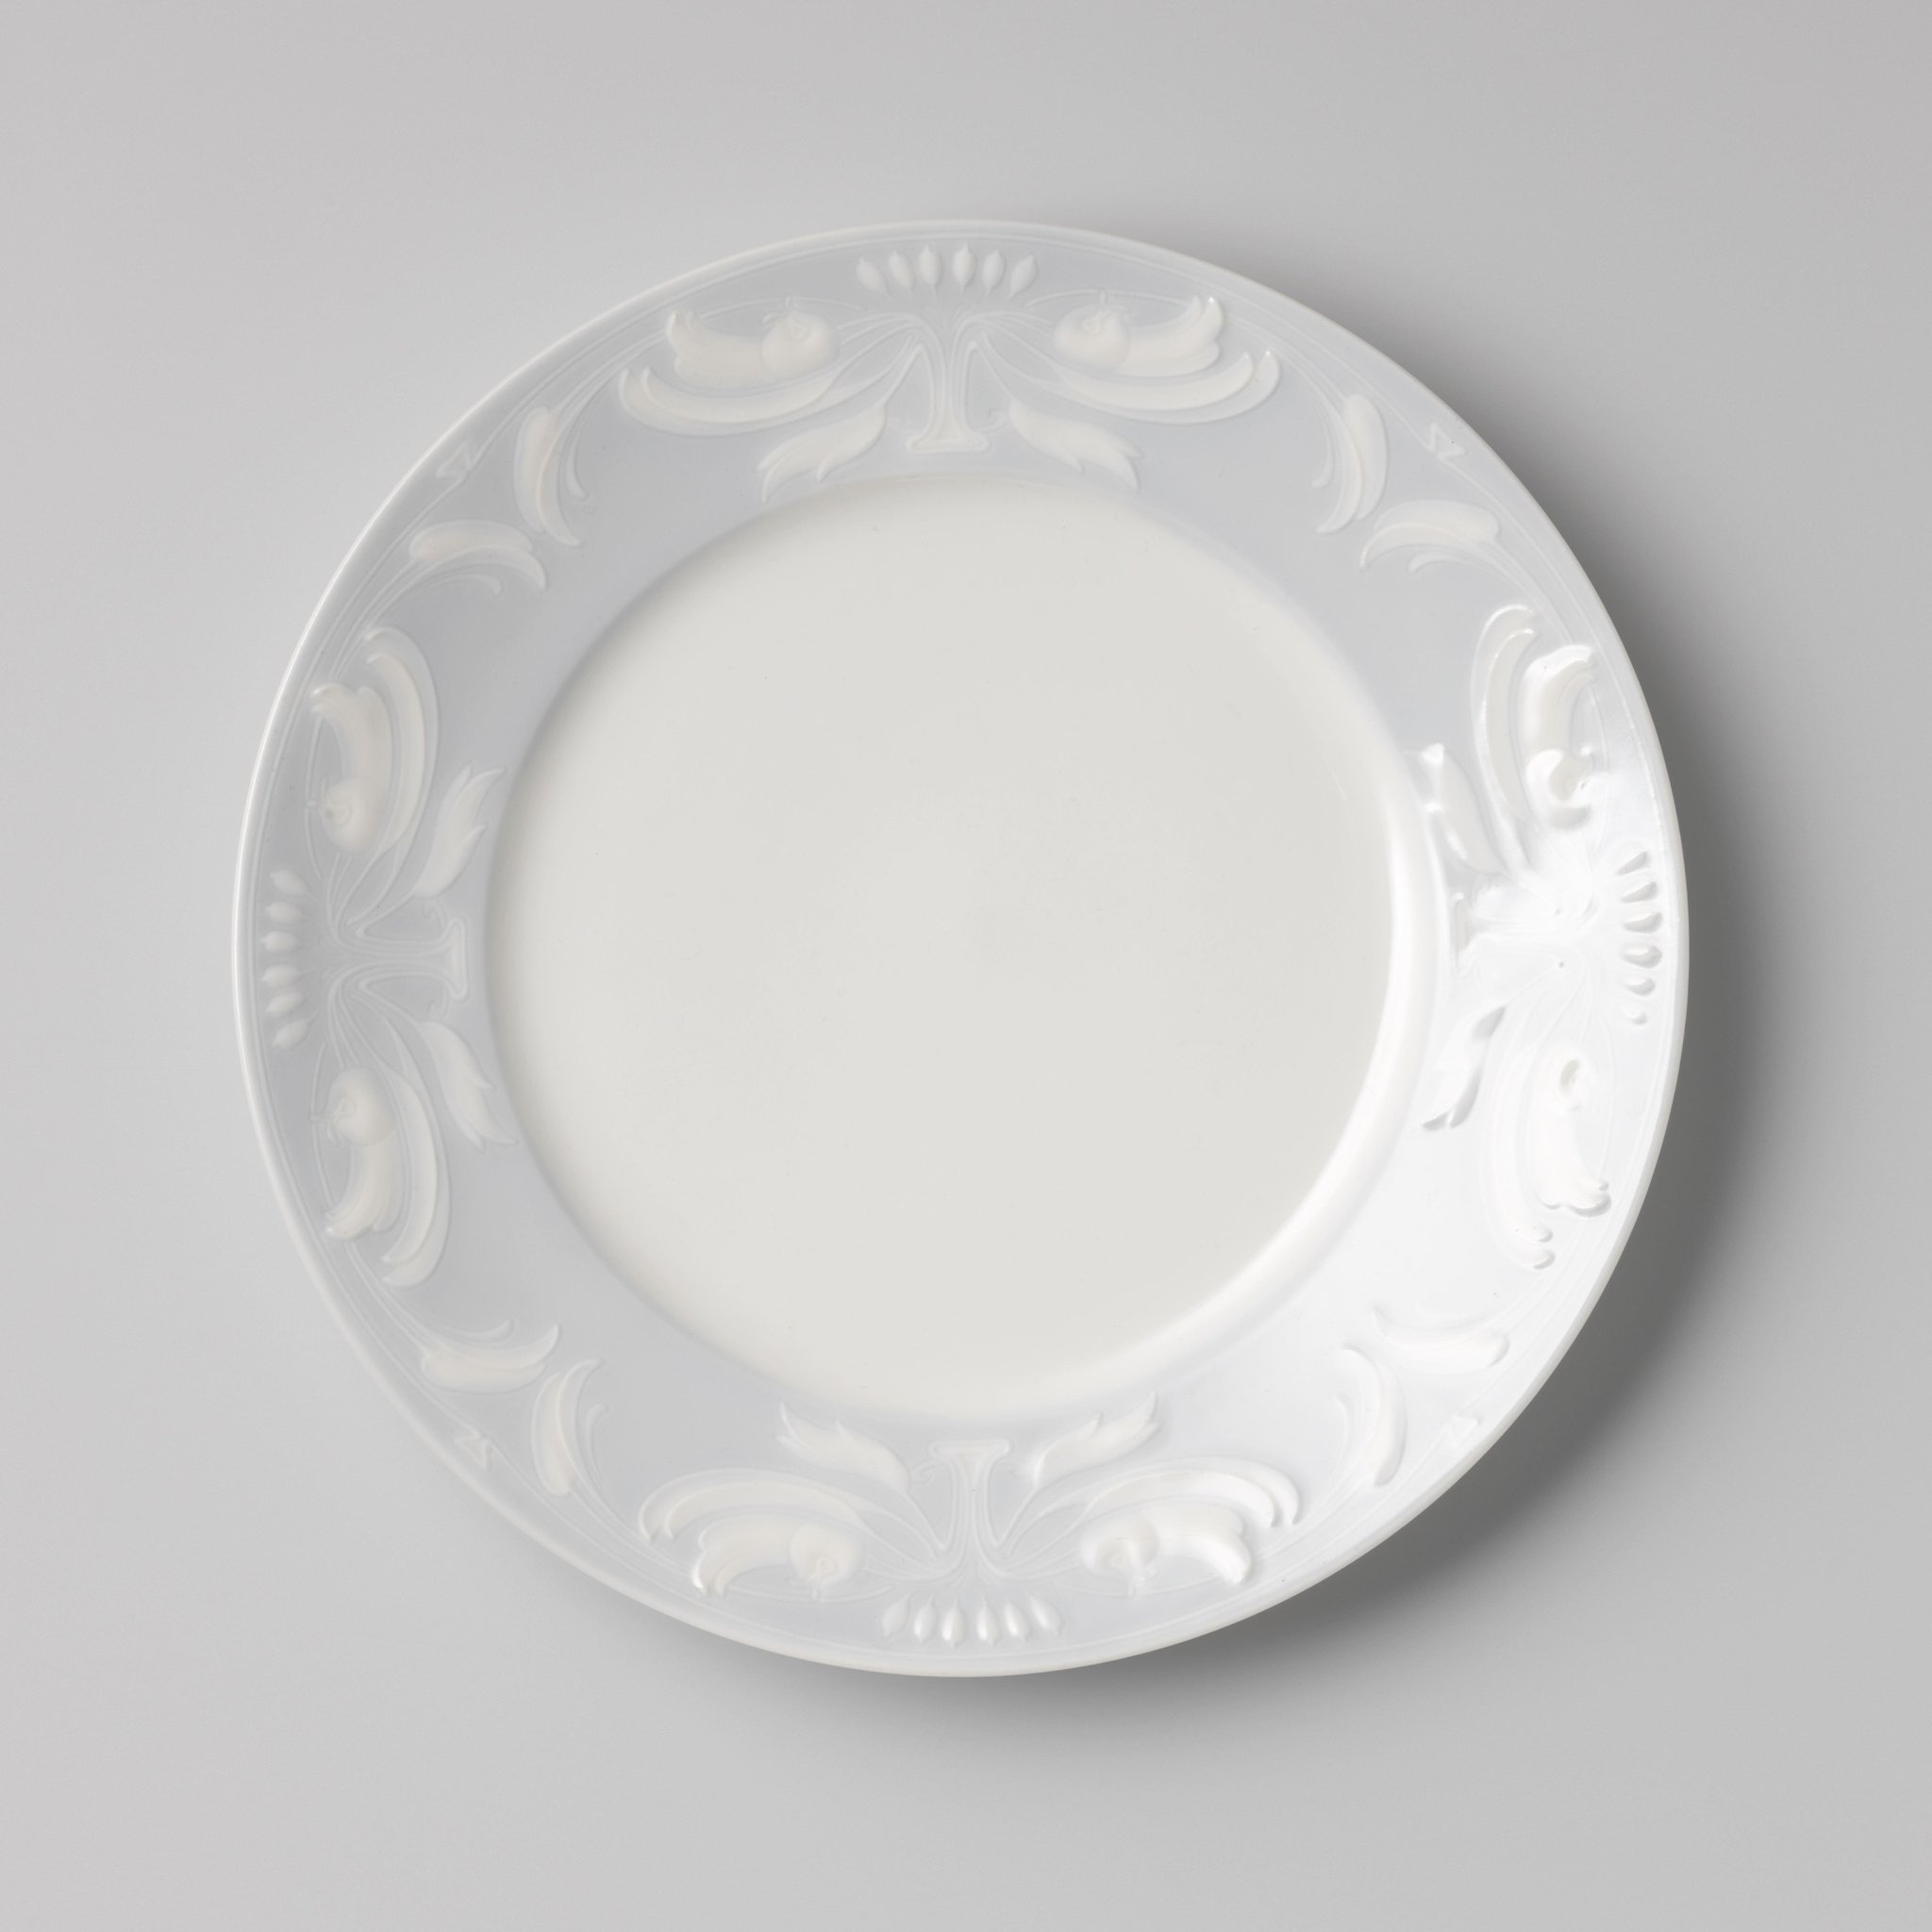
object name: eating drinking utensil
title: Dessertbord met symmetrische bladmotieven in reliëf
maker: georges de feure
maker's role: draughtsman, print maker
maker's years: 1868-1943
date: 1900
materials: porcelain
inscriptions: mark: ‘l'Art Nouveau Paris (in groen)’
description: Plate. Porcelain. Limoges, Gérard-Dufraisseix-Abbot, c. 1900, designed by George De Feure. Commissioned for the shop 'L'Art Nouveau' of Siegfried Bing, Paris.